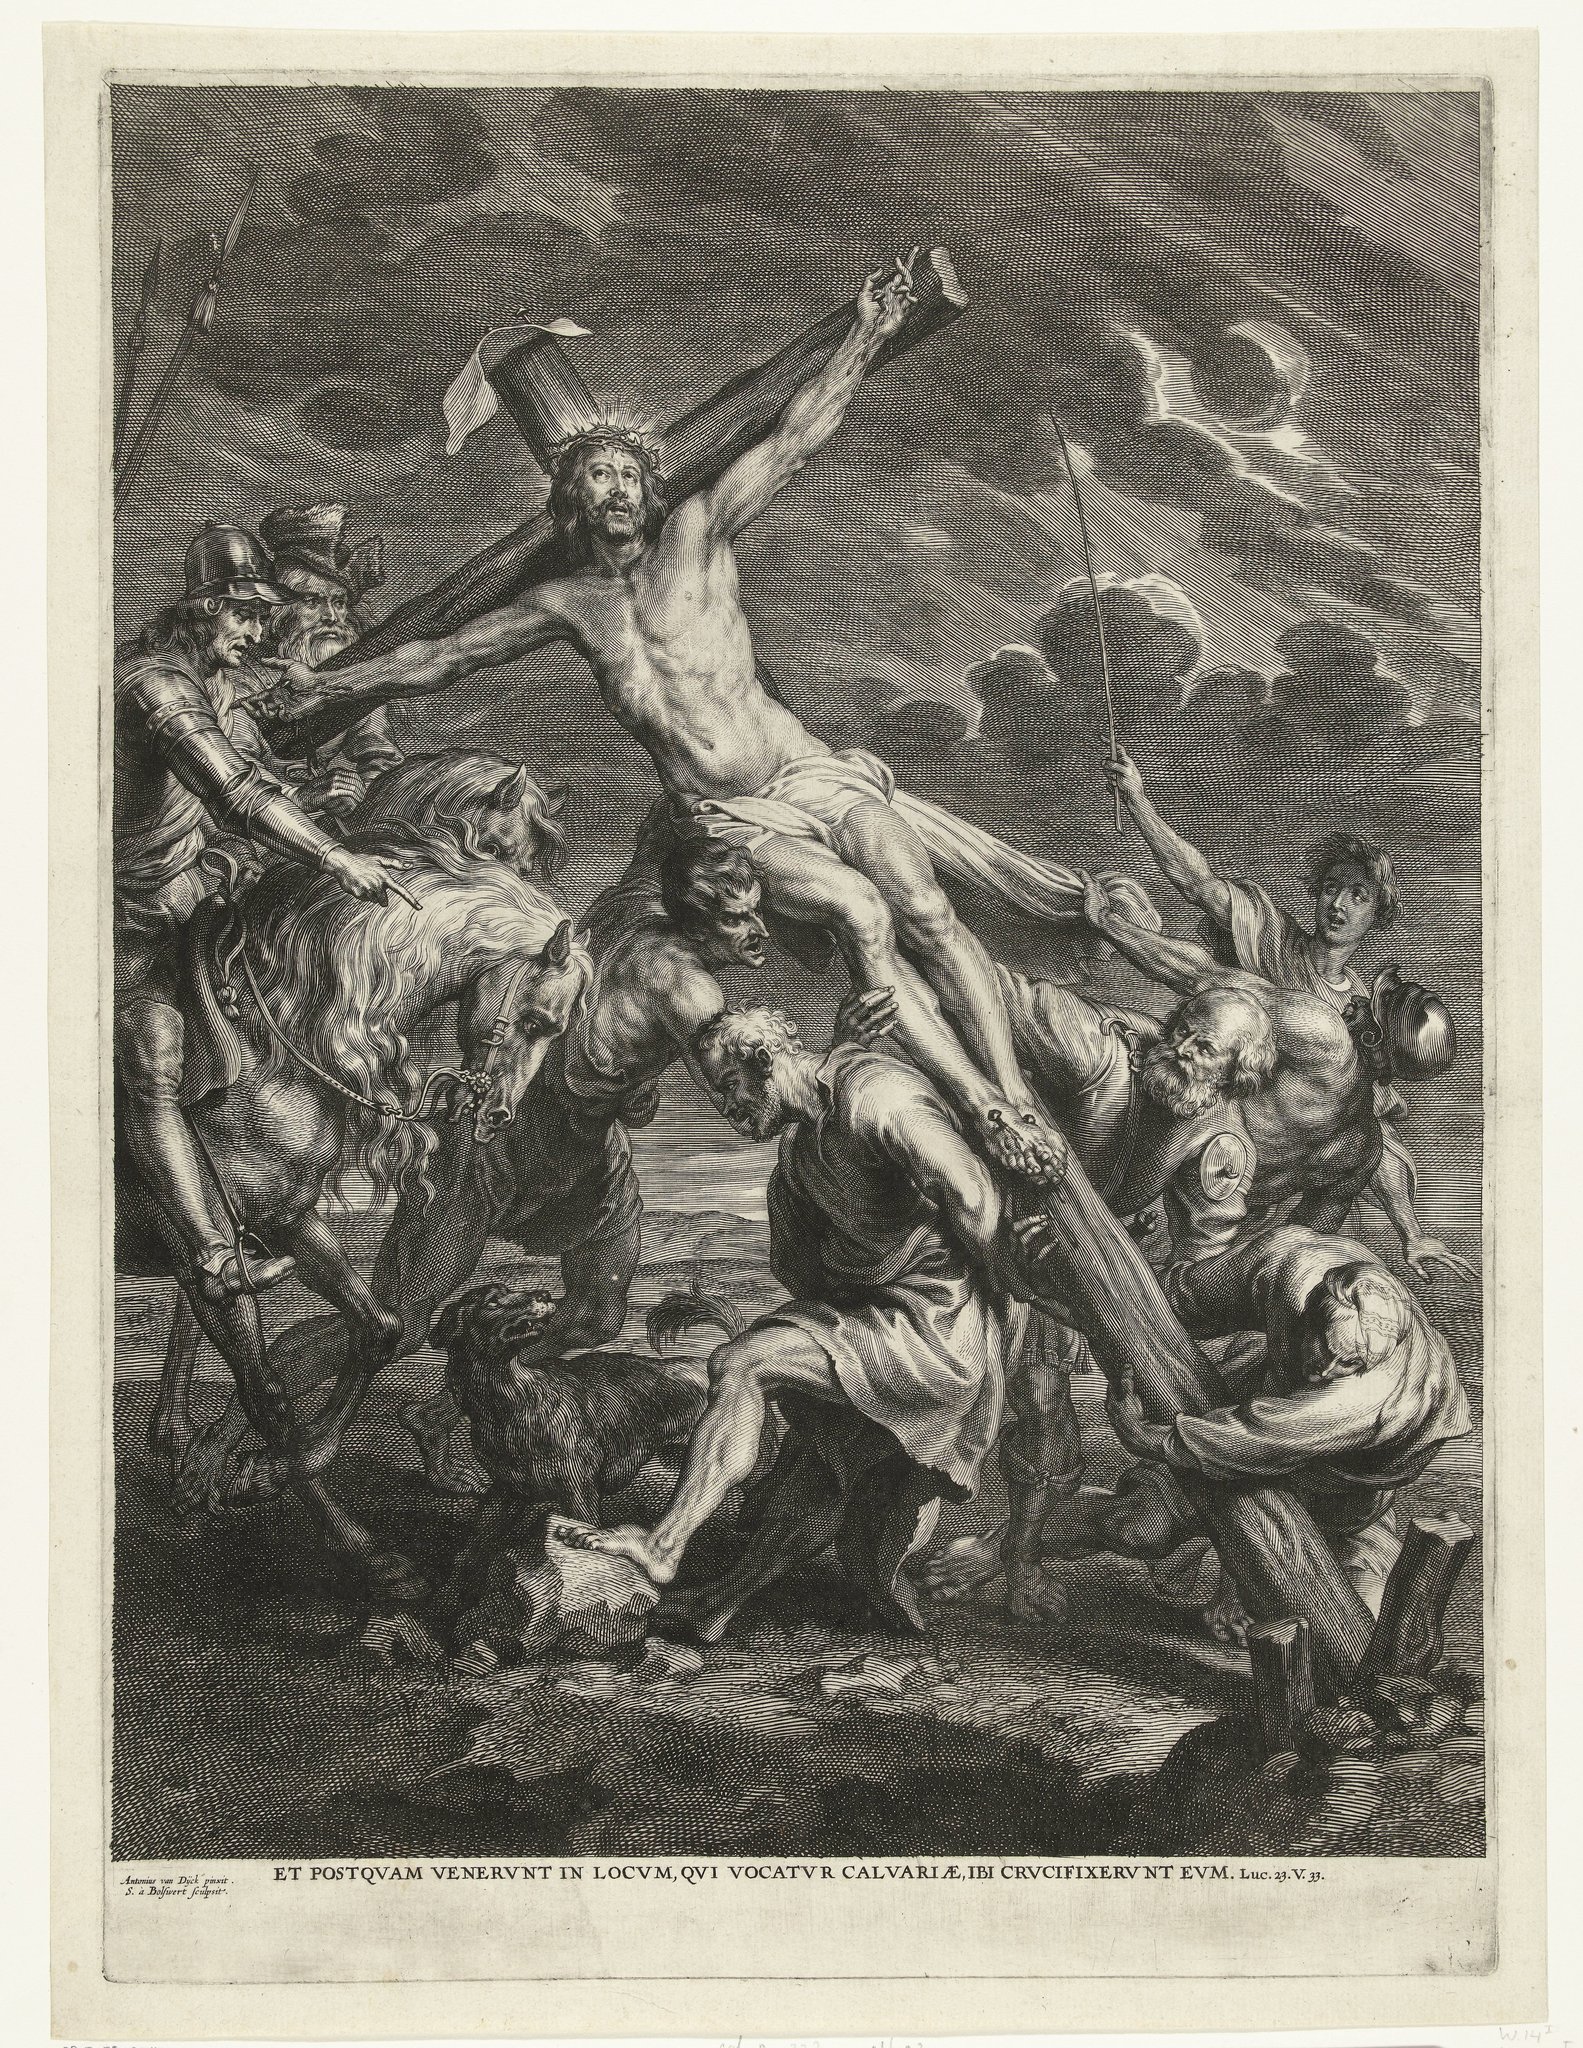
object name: print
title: Oprichting van het kruis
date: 1596-1659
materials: paper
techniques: engraving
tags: raising of the cross to which christ is nailed already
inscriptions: collector's mark: Lugt 240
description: Prent naar schilderij van Anthony van Dyck dat zich in de Onze-Lieve-Vrouwekerk te Kortrijk bevindt.